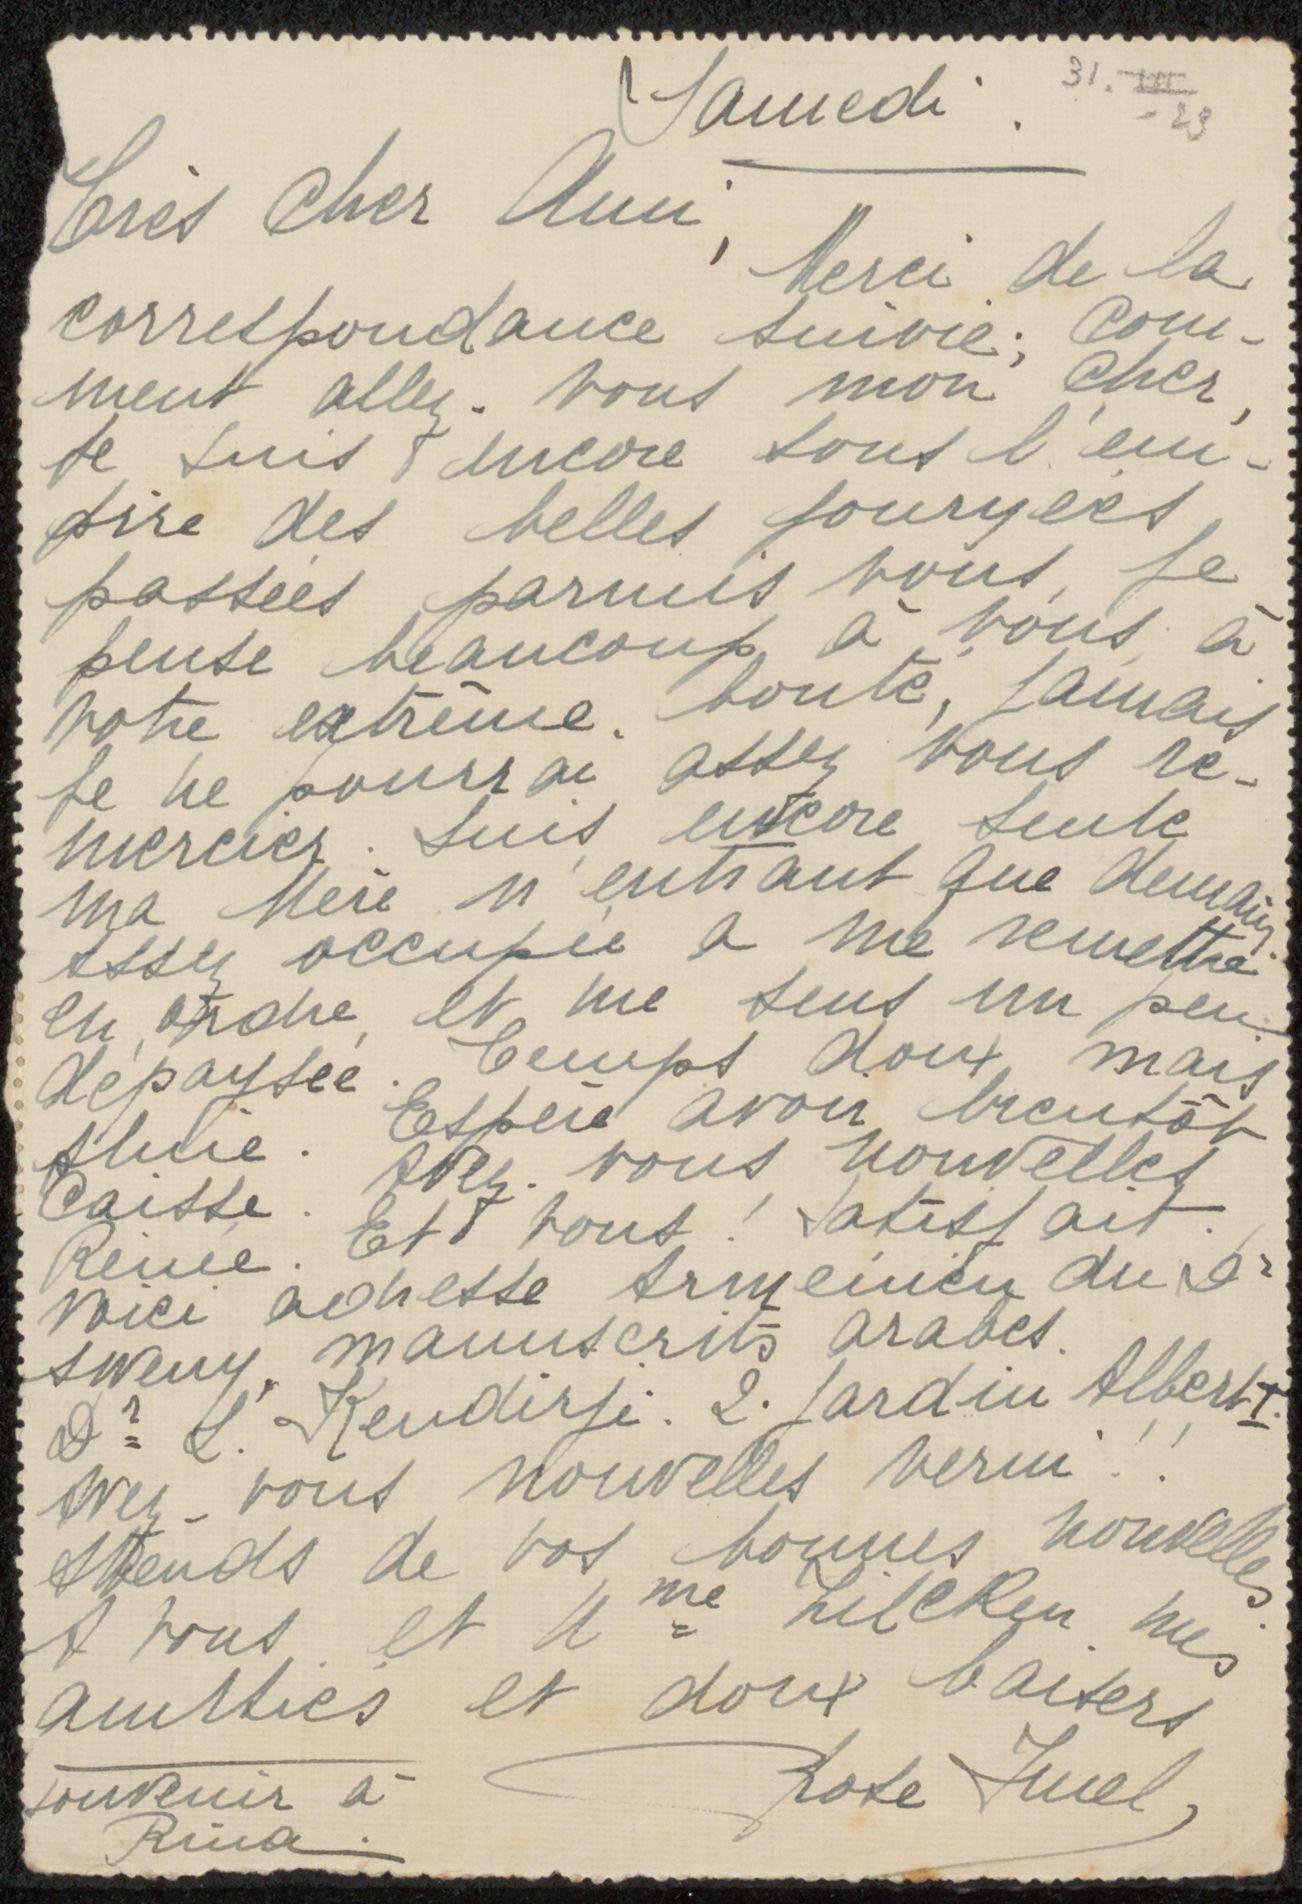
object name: letter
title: Brief aan Philip Zilcken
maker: rose imel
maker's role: draughtsman, painter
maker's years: 1901-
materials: ink, paper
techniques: pen, writing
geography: paris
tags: the hague, painter, draughtsman, philip zilcken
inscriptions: collector's mark: ‘RPK’